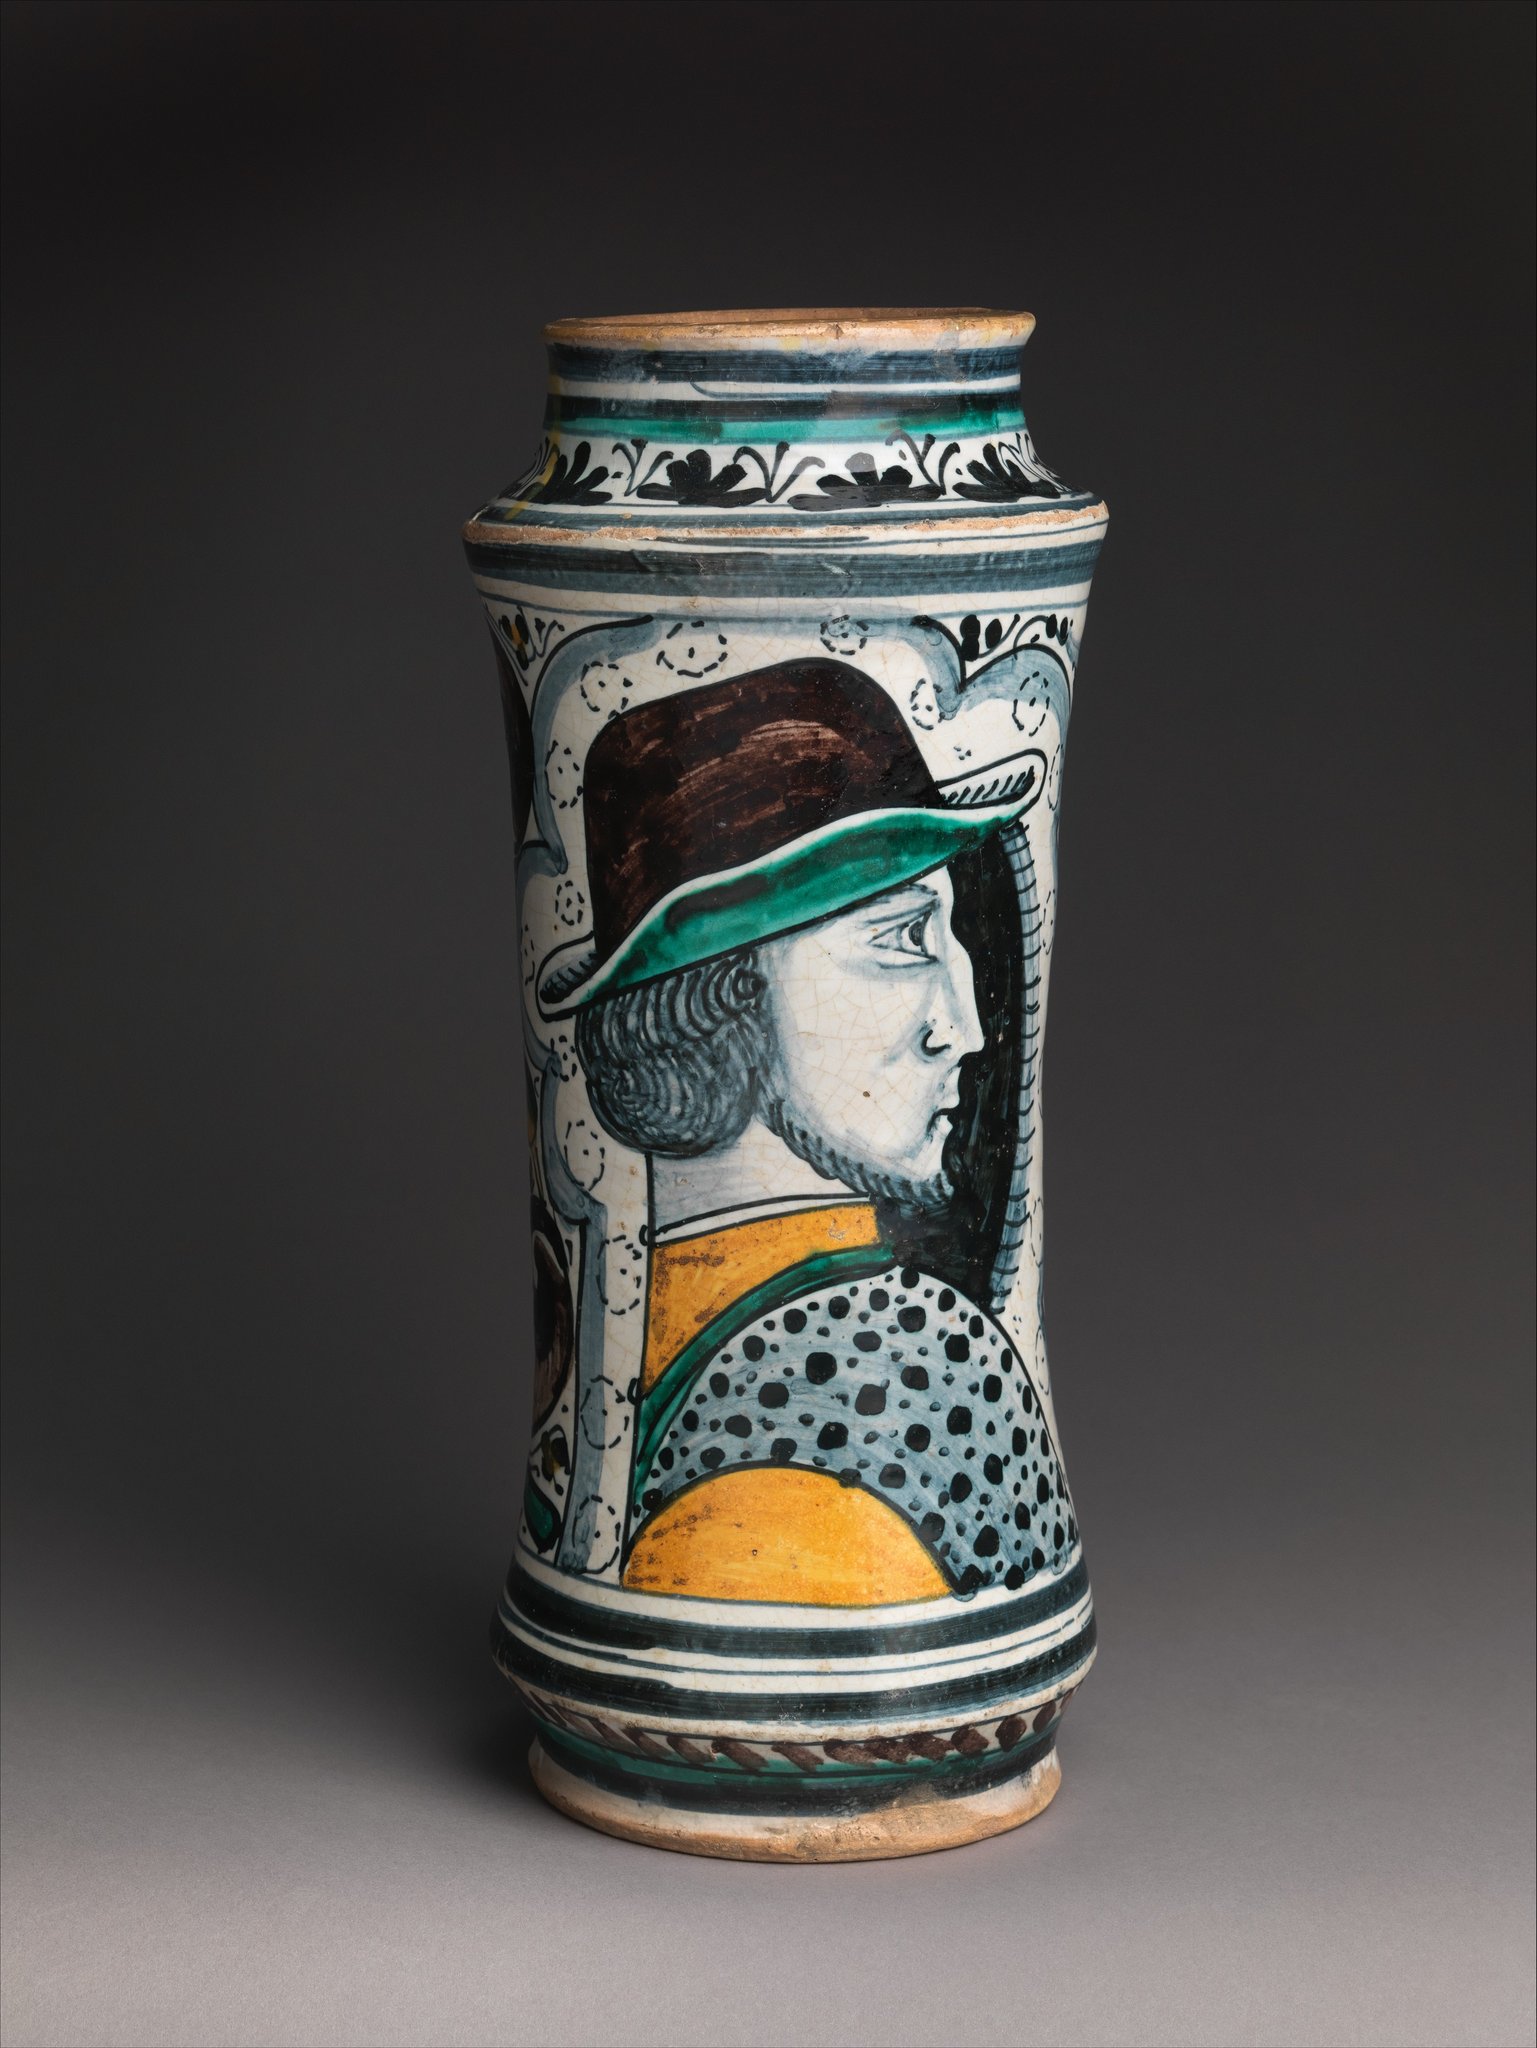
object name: storage jar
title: Storage jar (albarello) with a profile portrait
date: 1480-1500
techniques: maiolica, glazing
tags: men,profiles